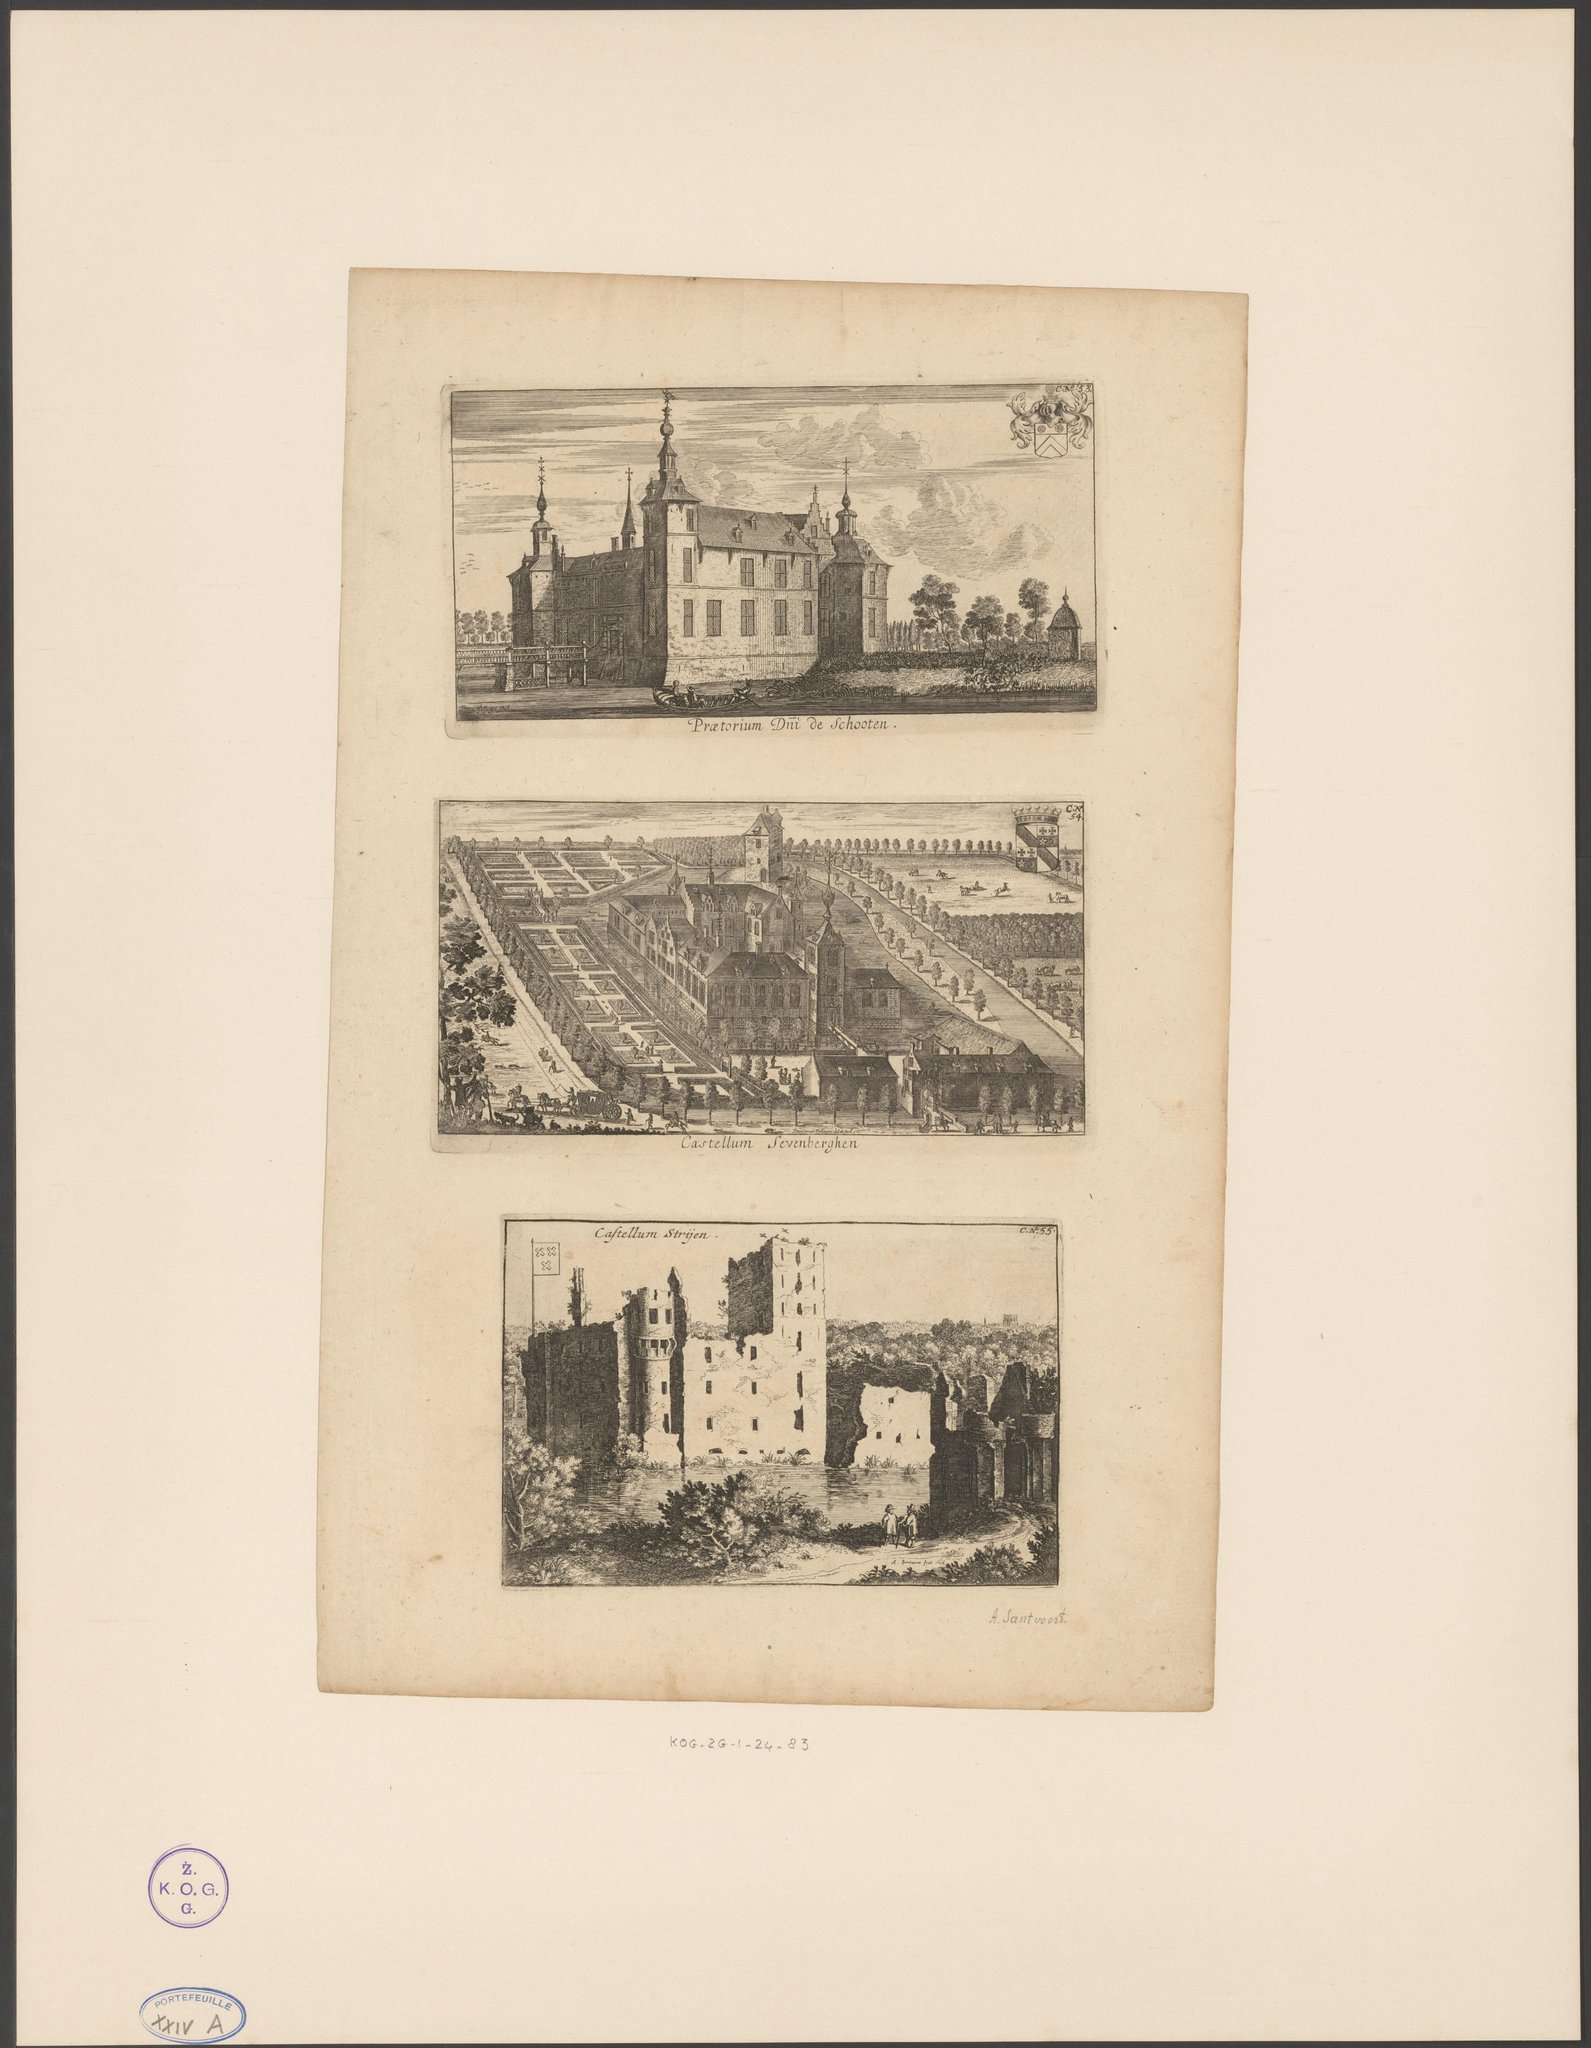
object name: print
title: Gezicht op het kasteel van Schoten, Kasteel Zevenbergen, Kasteel Strijen te Oosterhout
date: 1656-1730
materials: paper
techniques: engraving, etching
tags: castle, armorial bearing, heraldry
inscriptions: collector's mark: Lugt 1641, stamp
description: Van deze prenten bestaan in ieder geval vijf staten. De eerste staat is gebruikt in: Roys, Jacques le. Notitia Marchionatus Sacri Romani Imperii (…). Amsterdam: Franciscus Lamming, 1678. De tweede en derde staat komt voor in latere uitgaven van Le Roys werk (tweede: 1692, 1699, 1705, 1706; derde: 1730). De vierde staat is gebruikt in: Cantillons, Philippe de. Delices du Brabant et de ses campagnes (…). Amsterdam: Jean Neaulme, 1757. De vijfde staat komt voor in: Cantillon, Philippe de. Vermakelykheden van Brabant, en deszelfs onderhoorige landen (…). 4 dln. 1e druk. Amsterdam: David Weege, 1770, dl. 3. En in: Cantillon, Philippe de. Vermakelykheden van Brabant, en deszelfs onderhoorige landen (…). 4 dln. 2e druk. Utrecht: Gijsbert Tieme van Paddenburg en Justus Visch, 1777, dl. 3. Huidige staat is de tweede of derde staat.